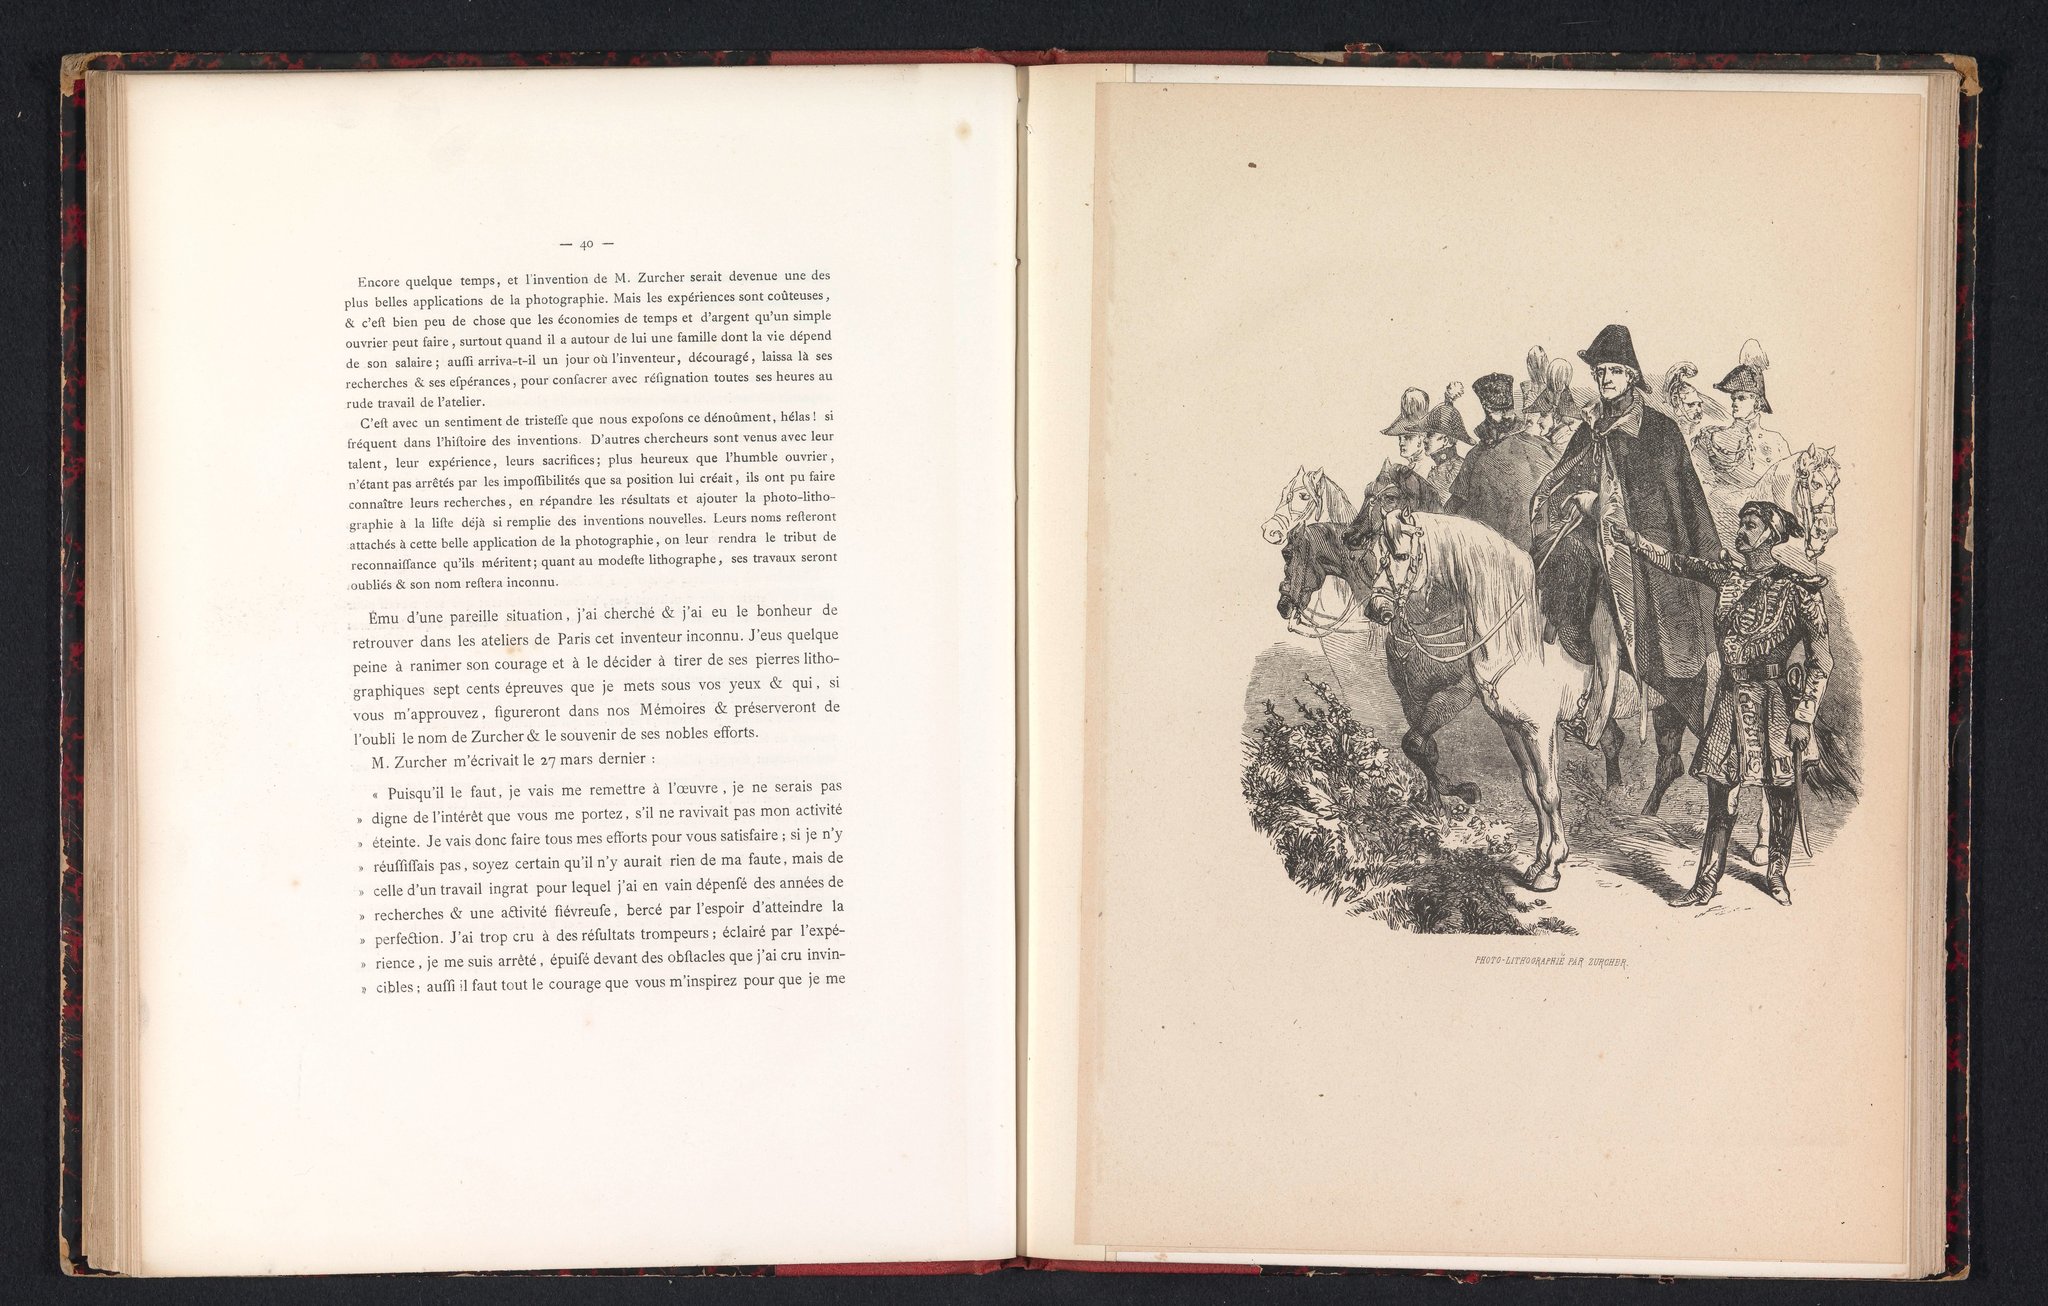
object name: page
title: Aanvoerder te paard met zijn gevolg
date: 1859-1869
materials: paper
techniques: photolithography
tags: riding a horse, ass, or mule; rider, horseman, commander-in-chief, general, marshal